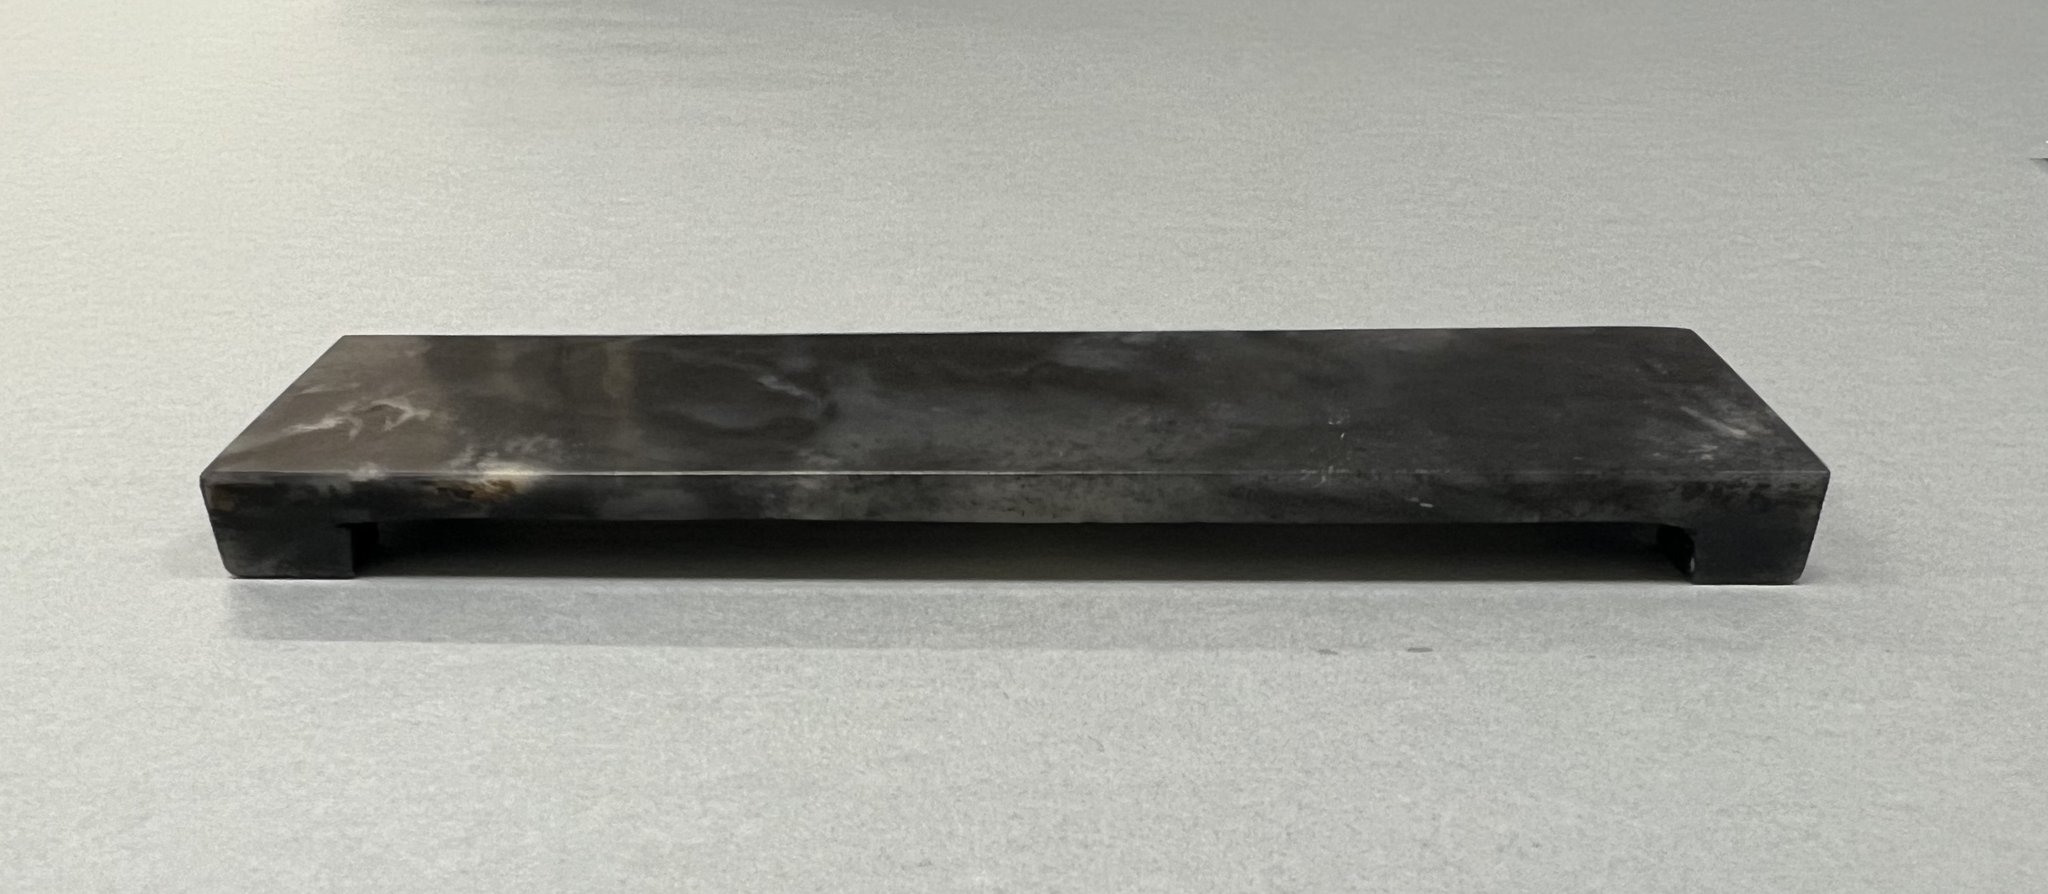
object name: ink rest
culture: chinese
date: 1801-1900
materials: jade